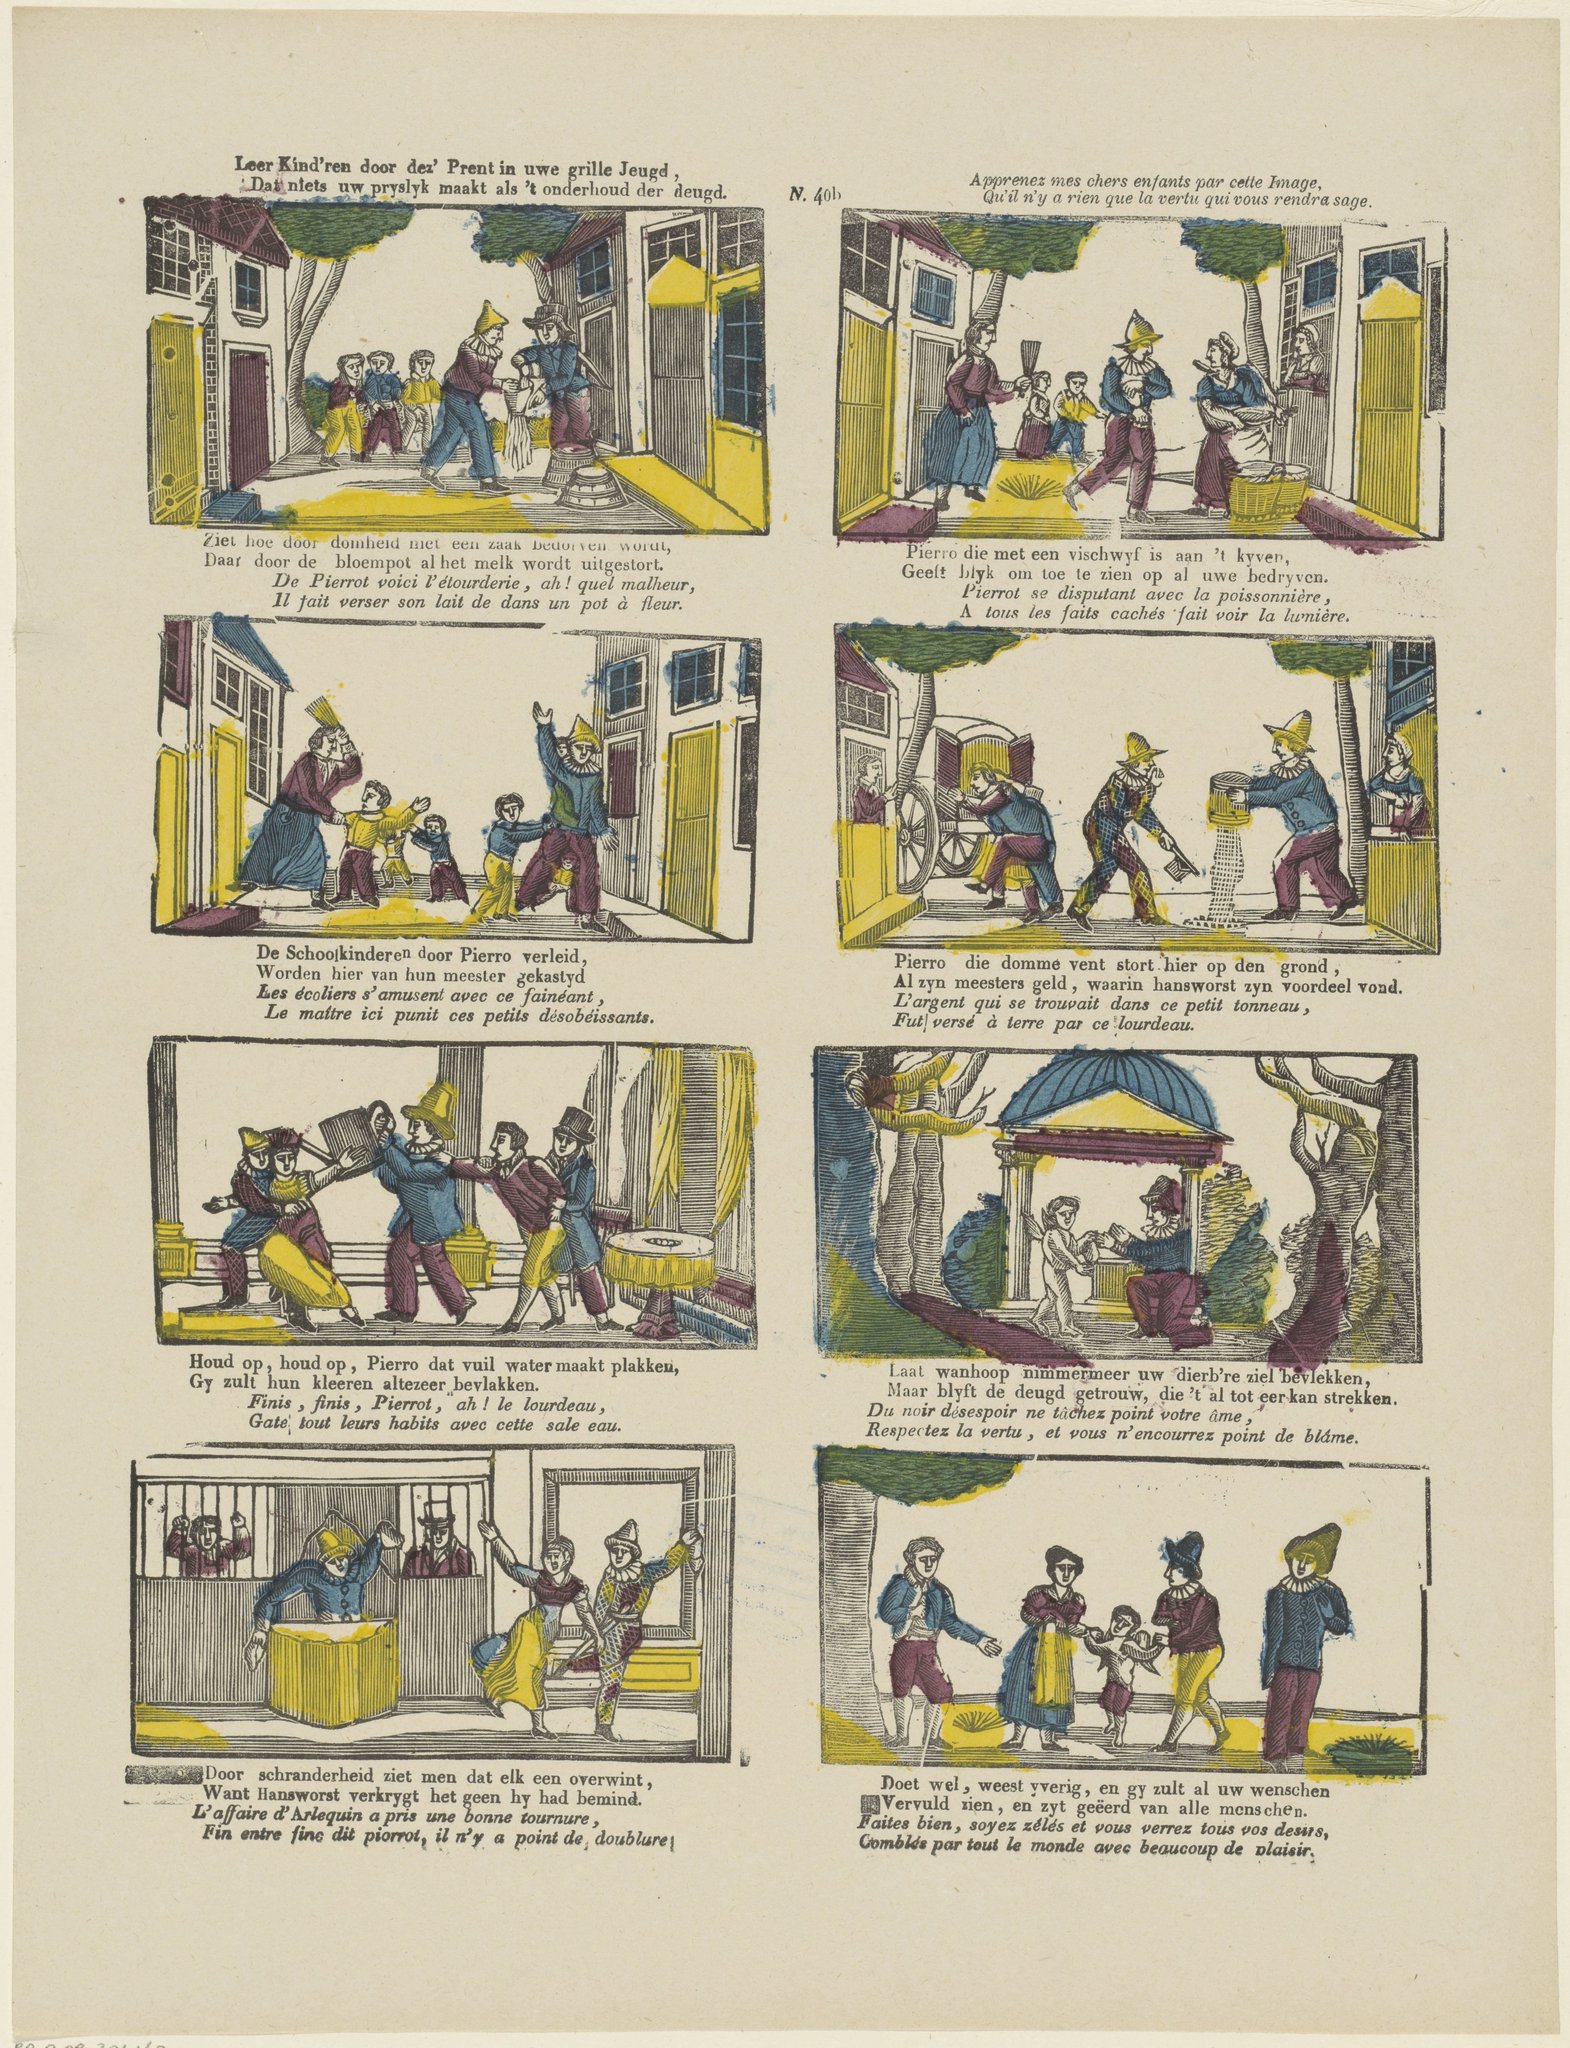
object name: popular print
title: Leer kind'ren door dez' prent in uwe grille jeugd, / Dat niets uw pryslyk maakt als 't onderhoud der deugd / Apprenez mes chers enfants par cette image, / Qu'il n'y a rien que la vertu qui vous rendra sage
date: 1866-1902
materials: paper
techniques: colour, letterpress printing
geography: europe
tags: types in 'commedia dell'arte': pierrot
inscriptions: collector's mark: ‘Edw. Ipers / Oever 27, / Antwerpen.’, collector's mark: Lugt 2760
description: Blad met 8 voorstellingen over de avonturen van Pierrot. Onder elke afbeelding een tweeregelig vers in het Nederlands en in het Frans. Genummerd midden boven: N. 40b.